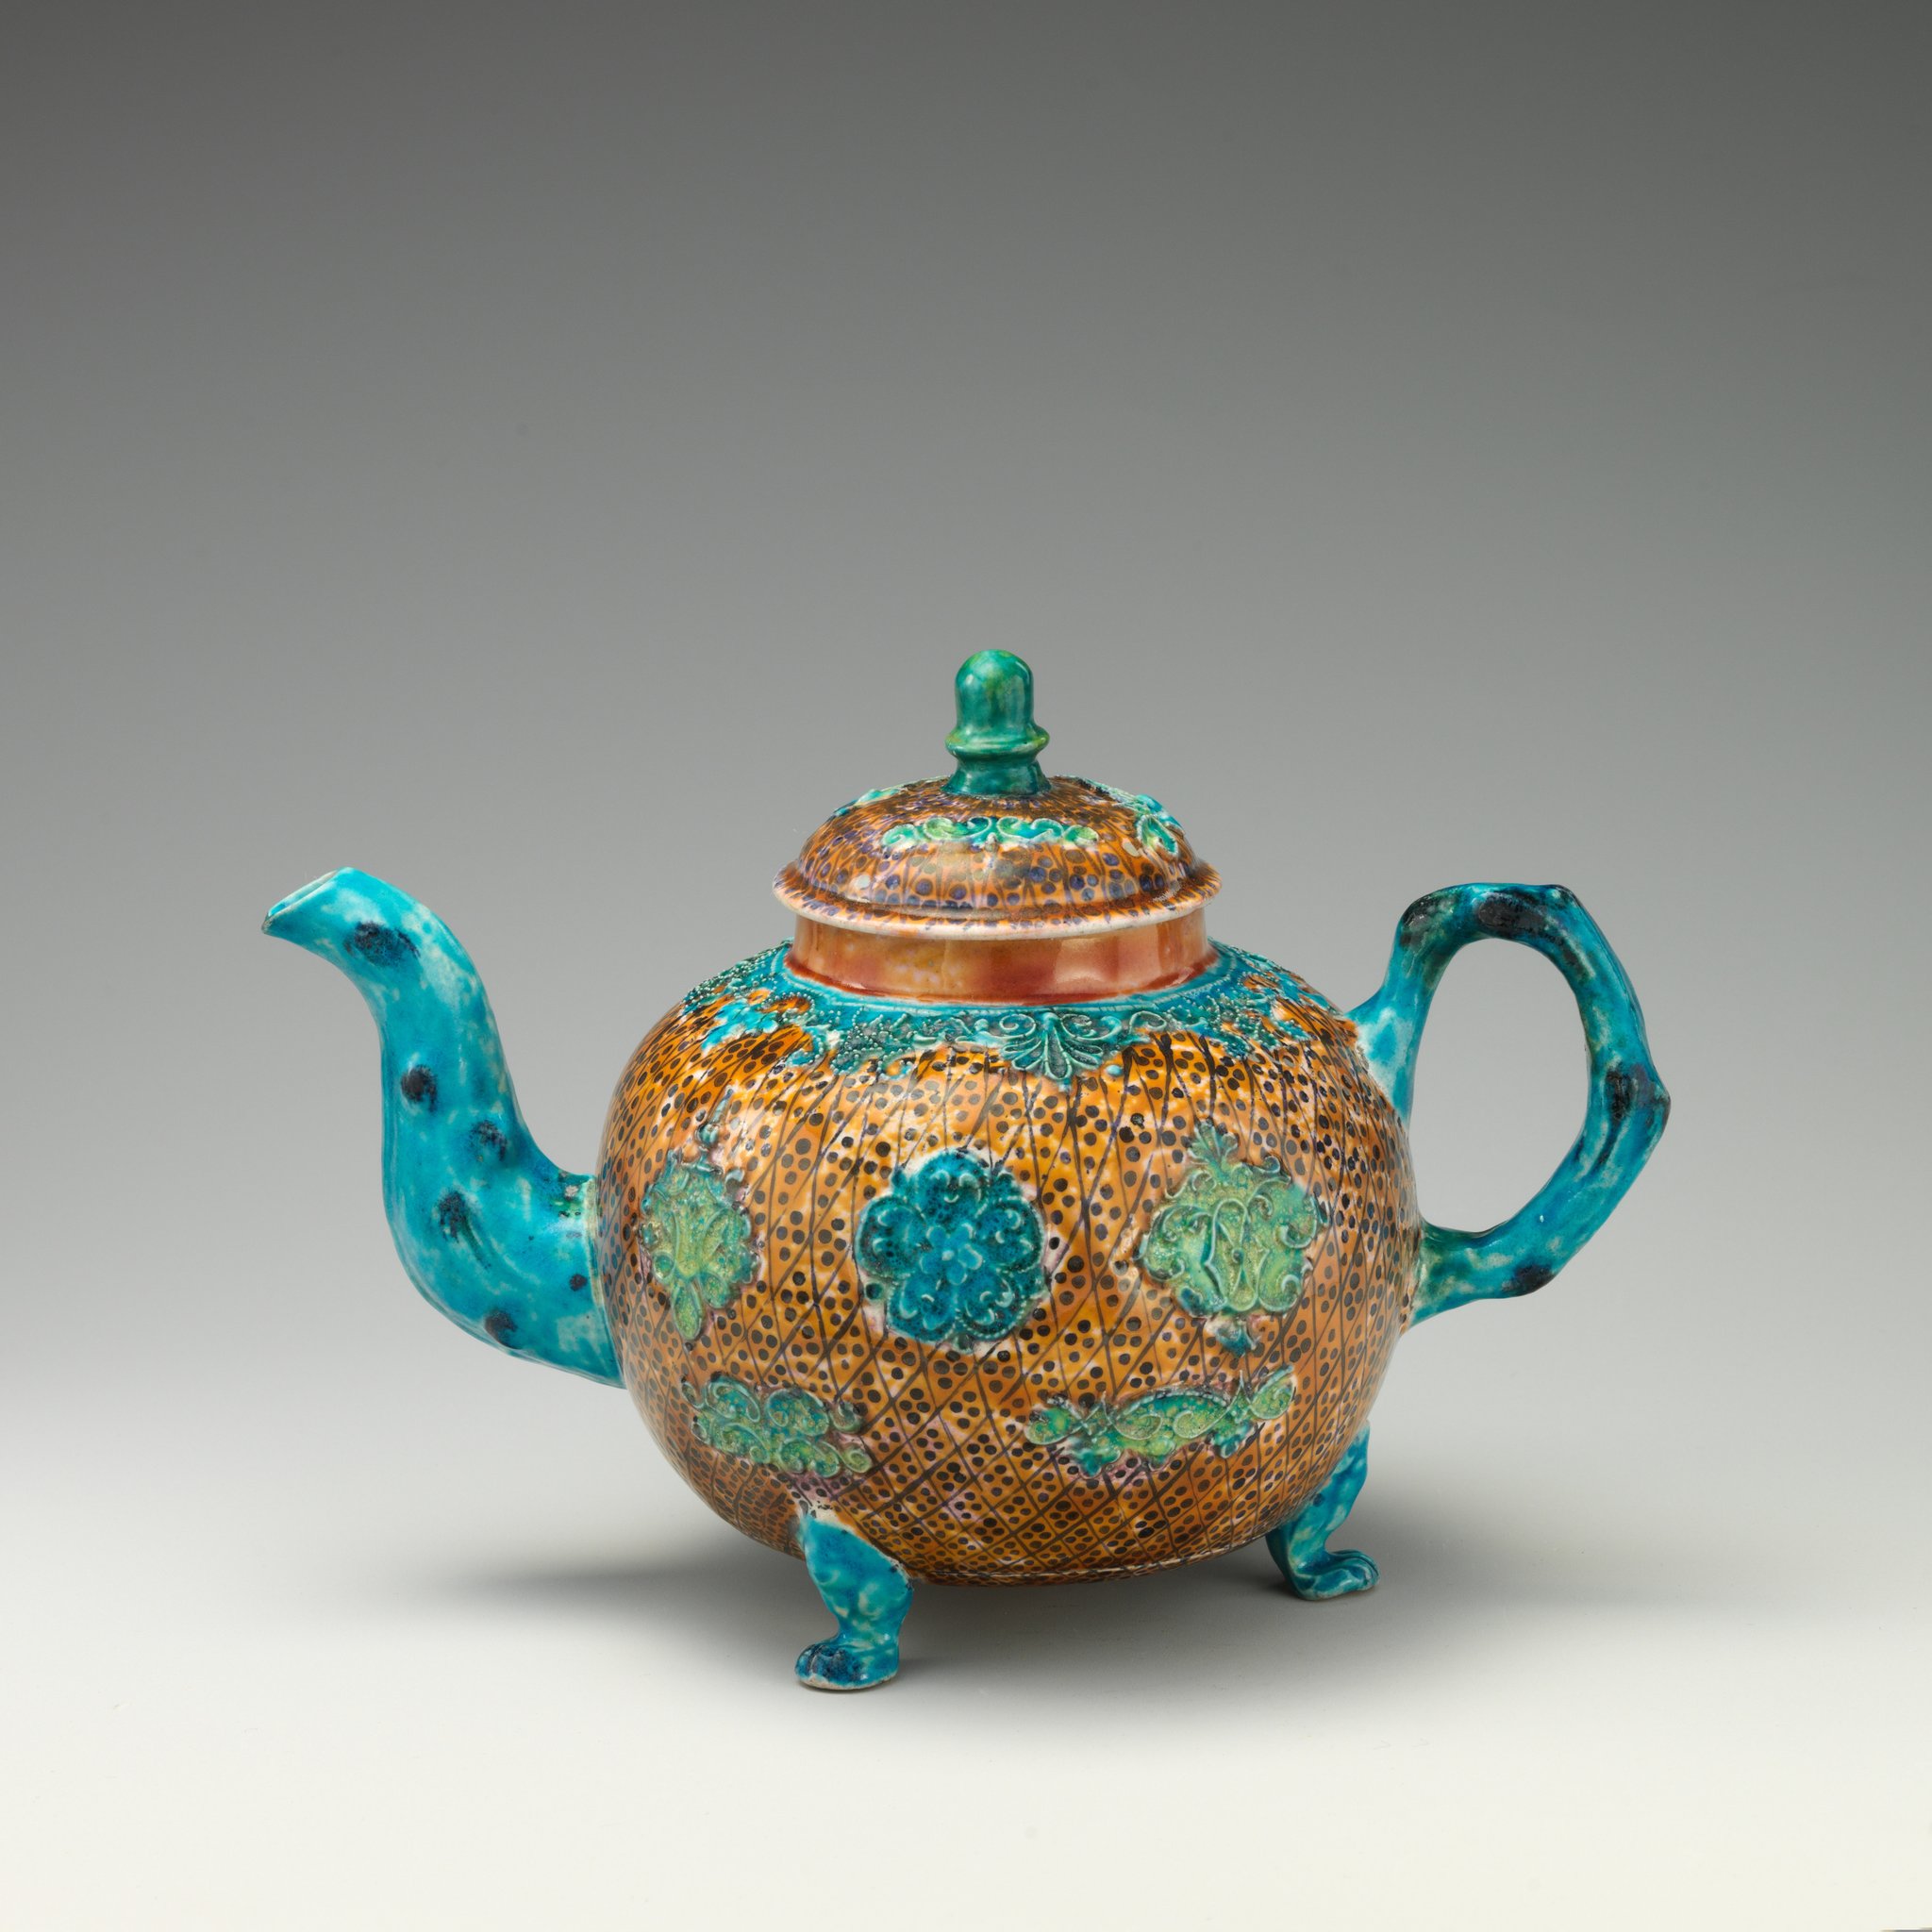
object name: teapot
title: Footed teapot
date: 1760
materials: enamel, stoneware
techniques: salt glaze